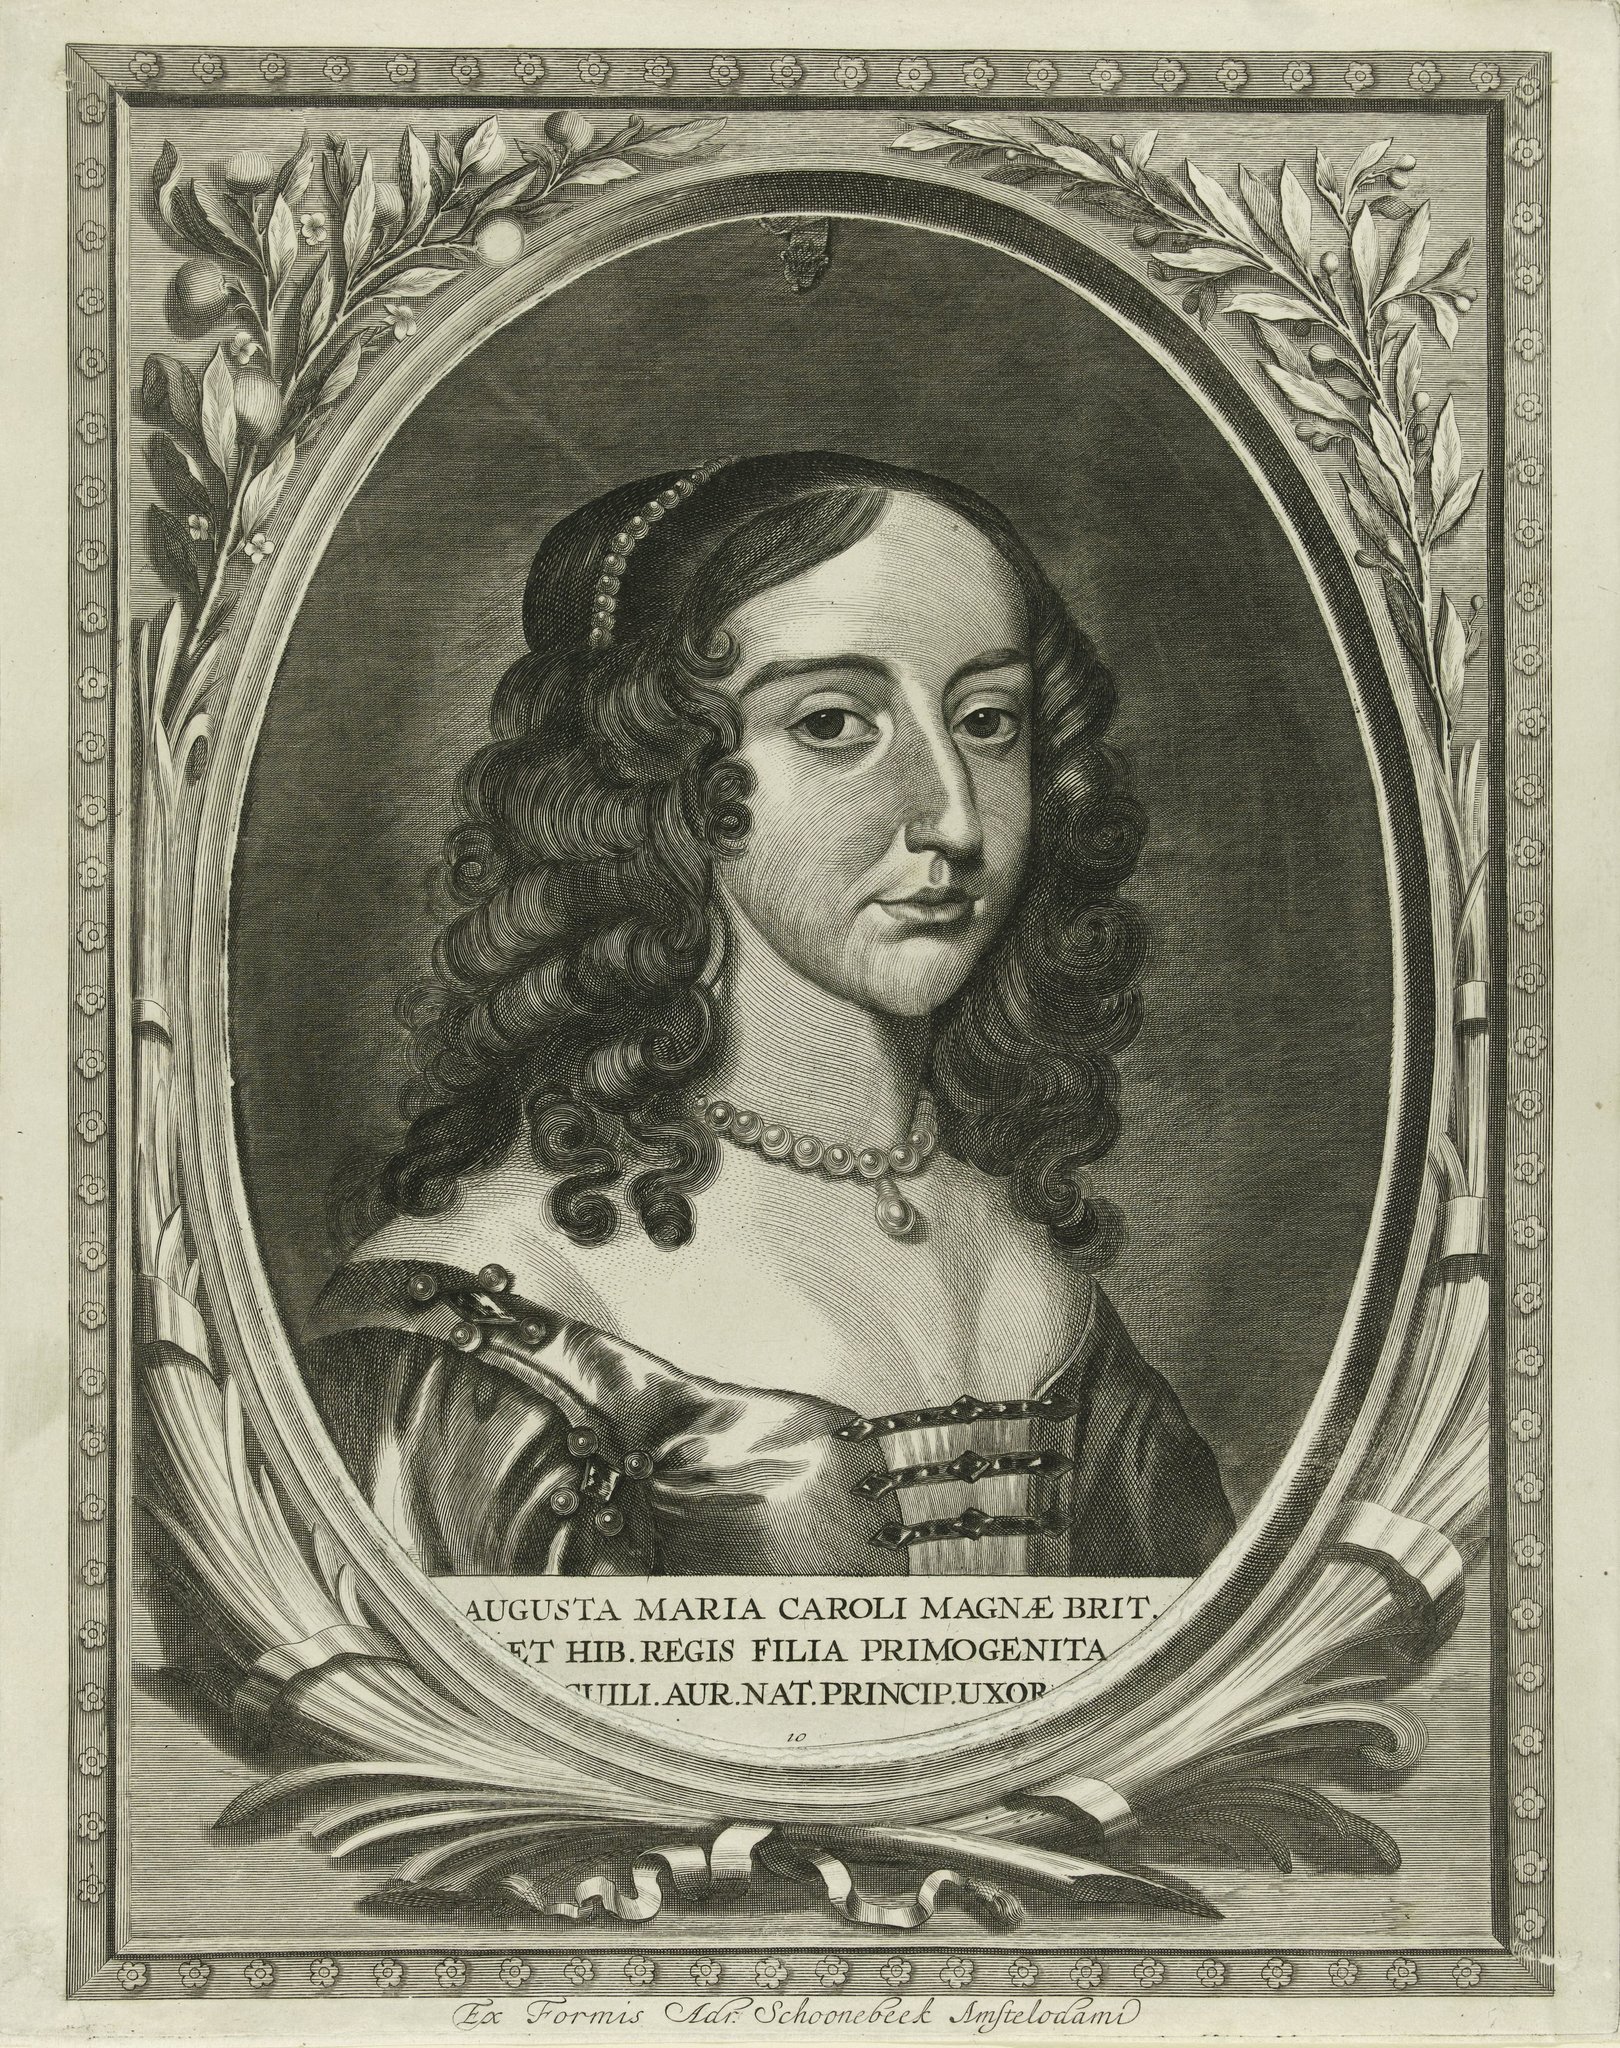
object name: print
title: Portret van Maria Henrietta Stuart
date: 1688-1698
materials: paper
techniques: engraving, etching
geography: haarlem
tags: london, mary henrietta stuart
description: Portret van Maria Henrietta. In een kader haar naam en titels. Geheel in een afzonderlijk gegraveerde ovale omlijsting met takken en linten.